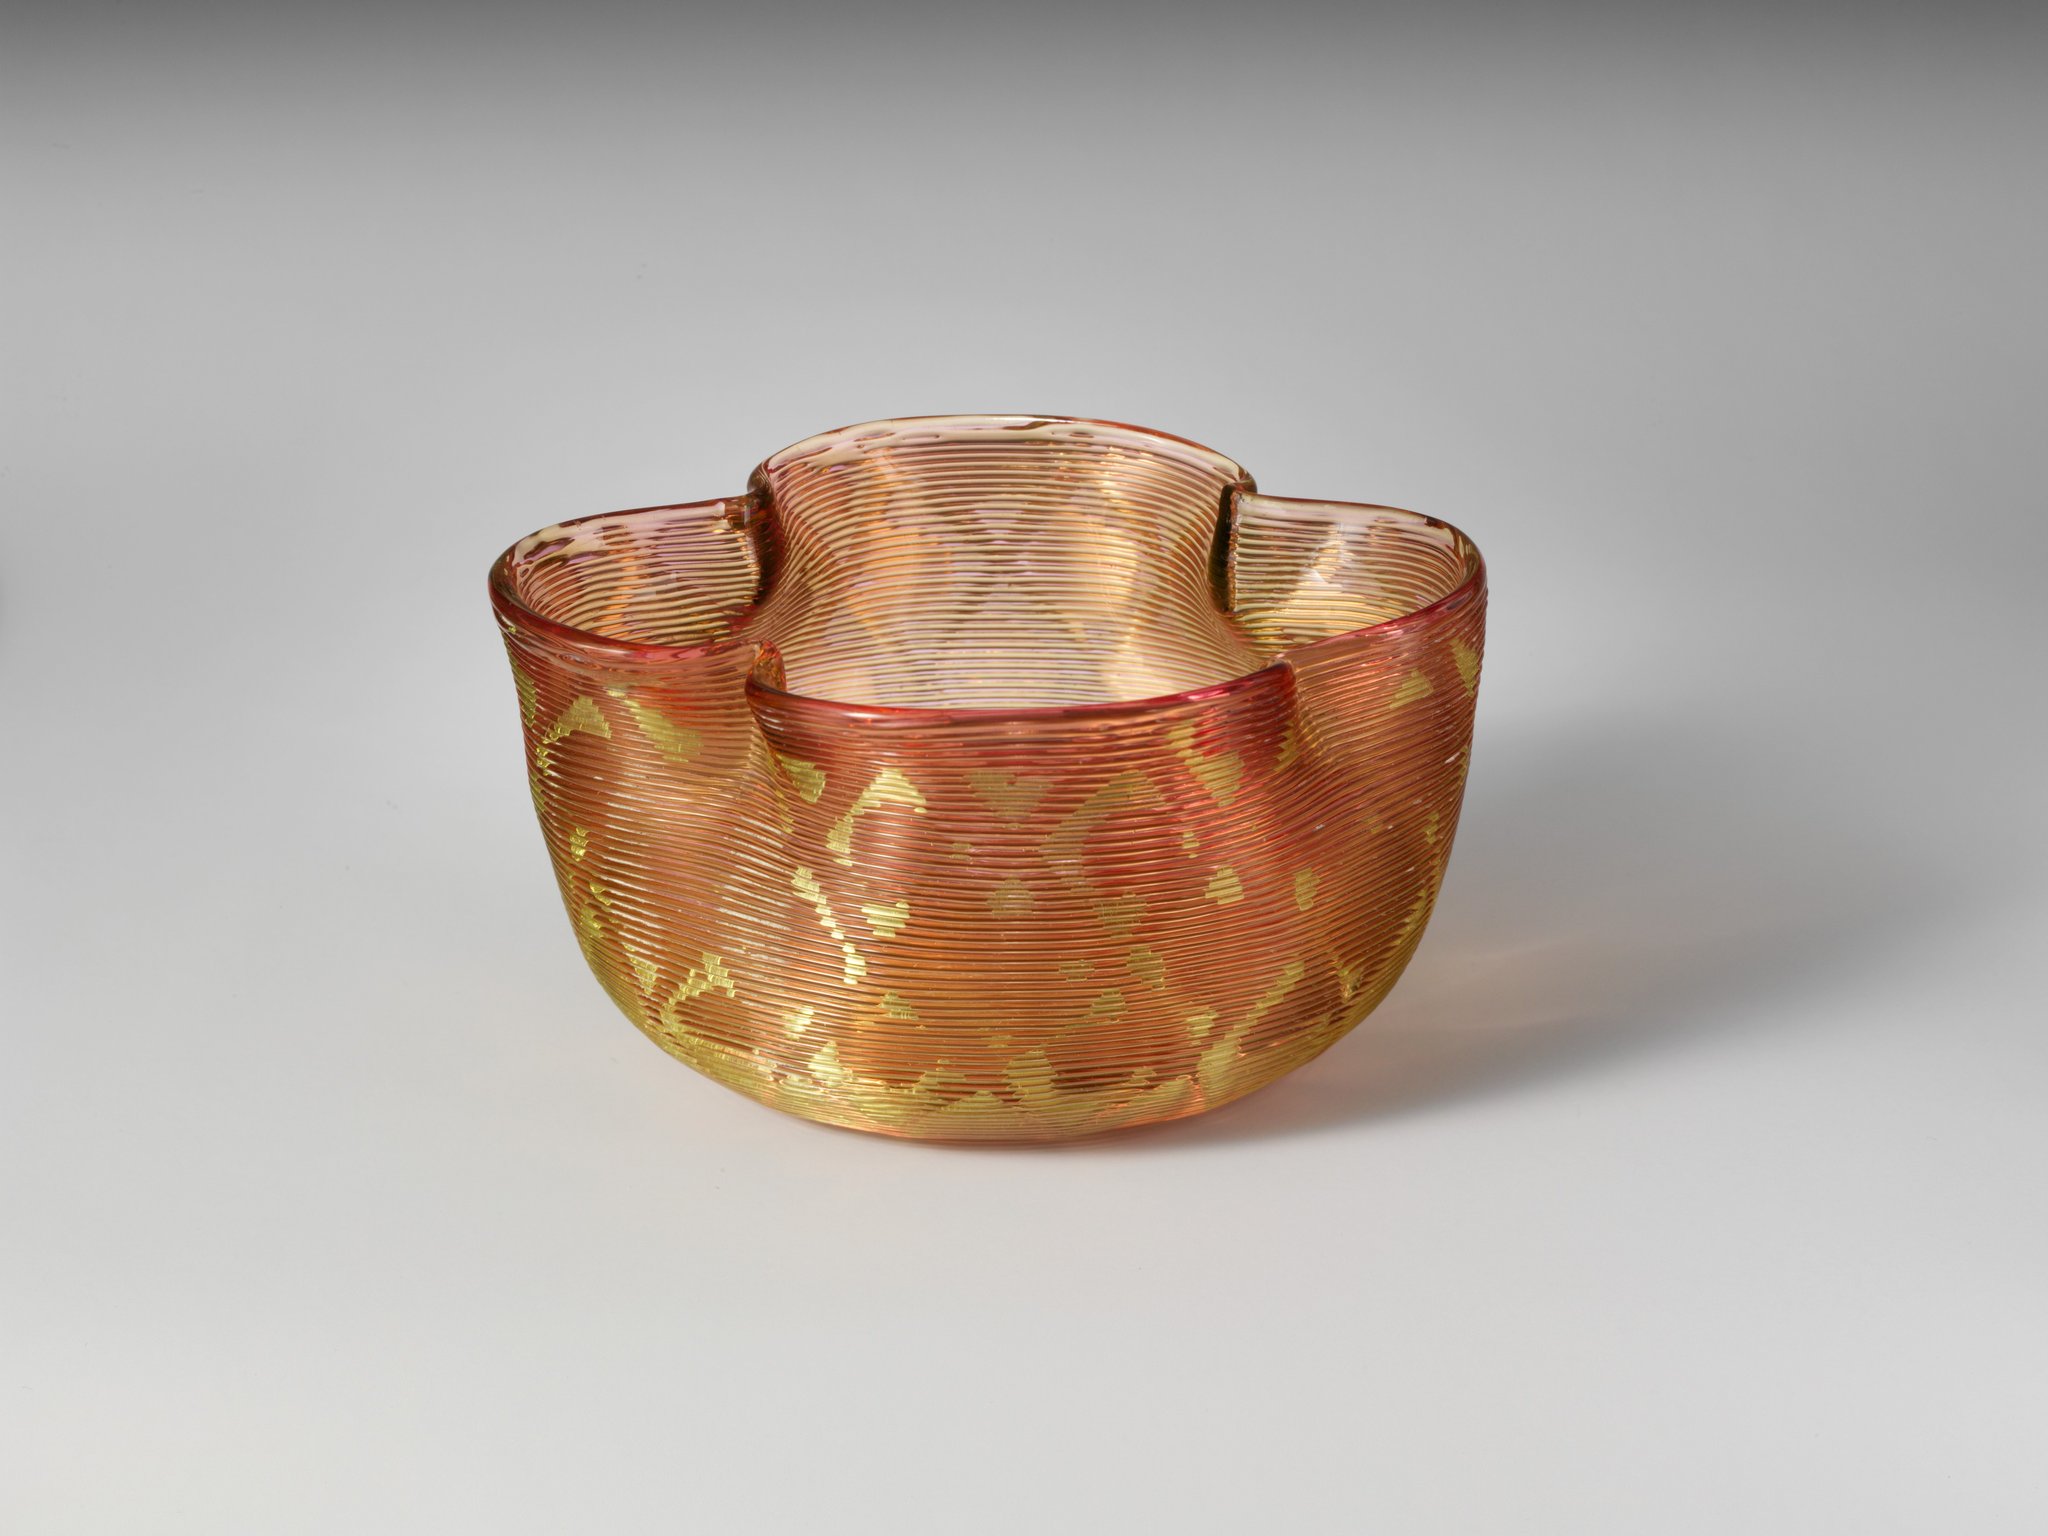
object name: finger bowl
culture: american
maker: boston & sandwich glass company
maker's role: maker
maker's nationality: american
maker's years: 1825-1888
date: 1880-1888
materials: amber, glass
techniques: glassblowing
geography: united states